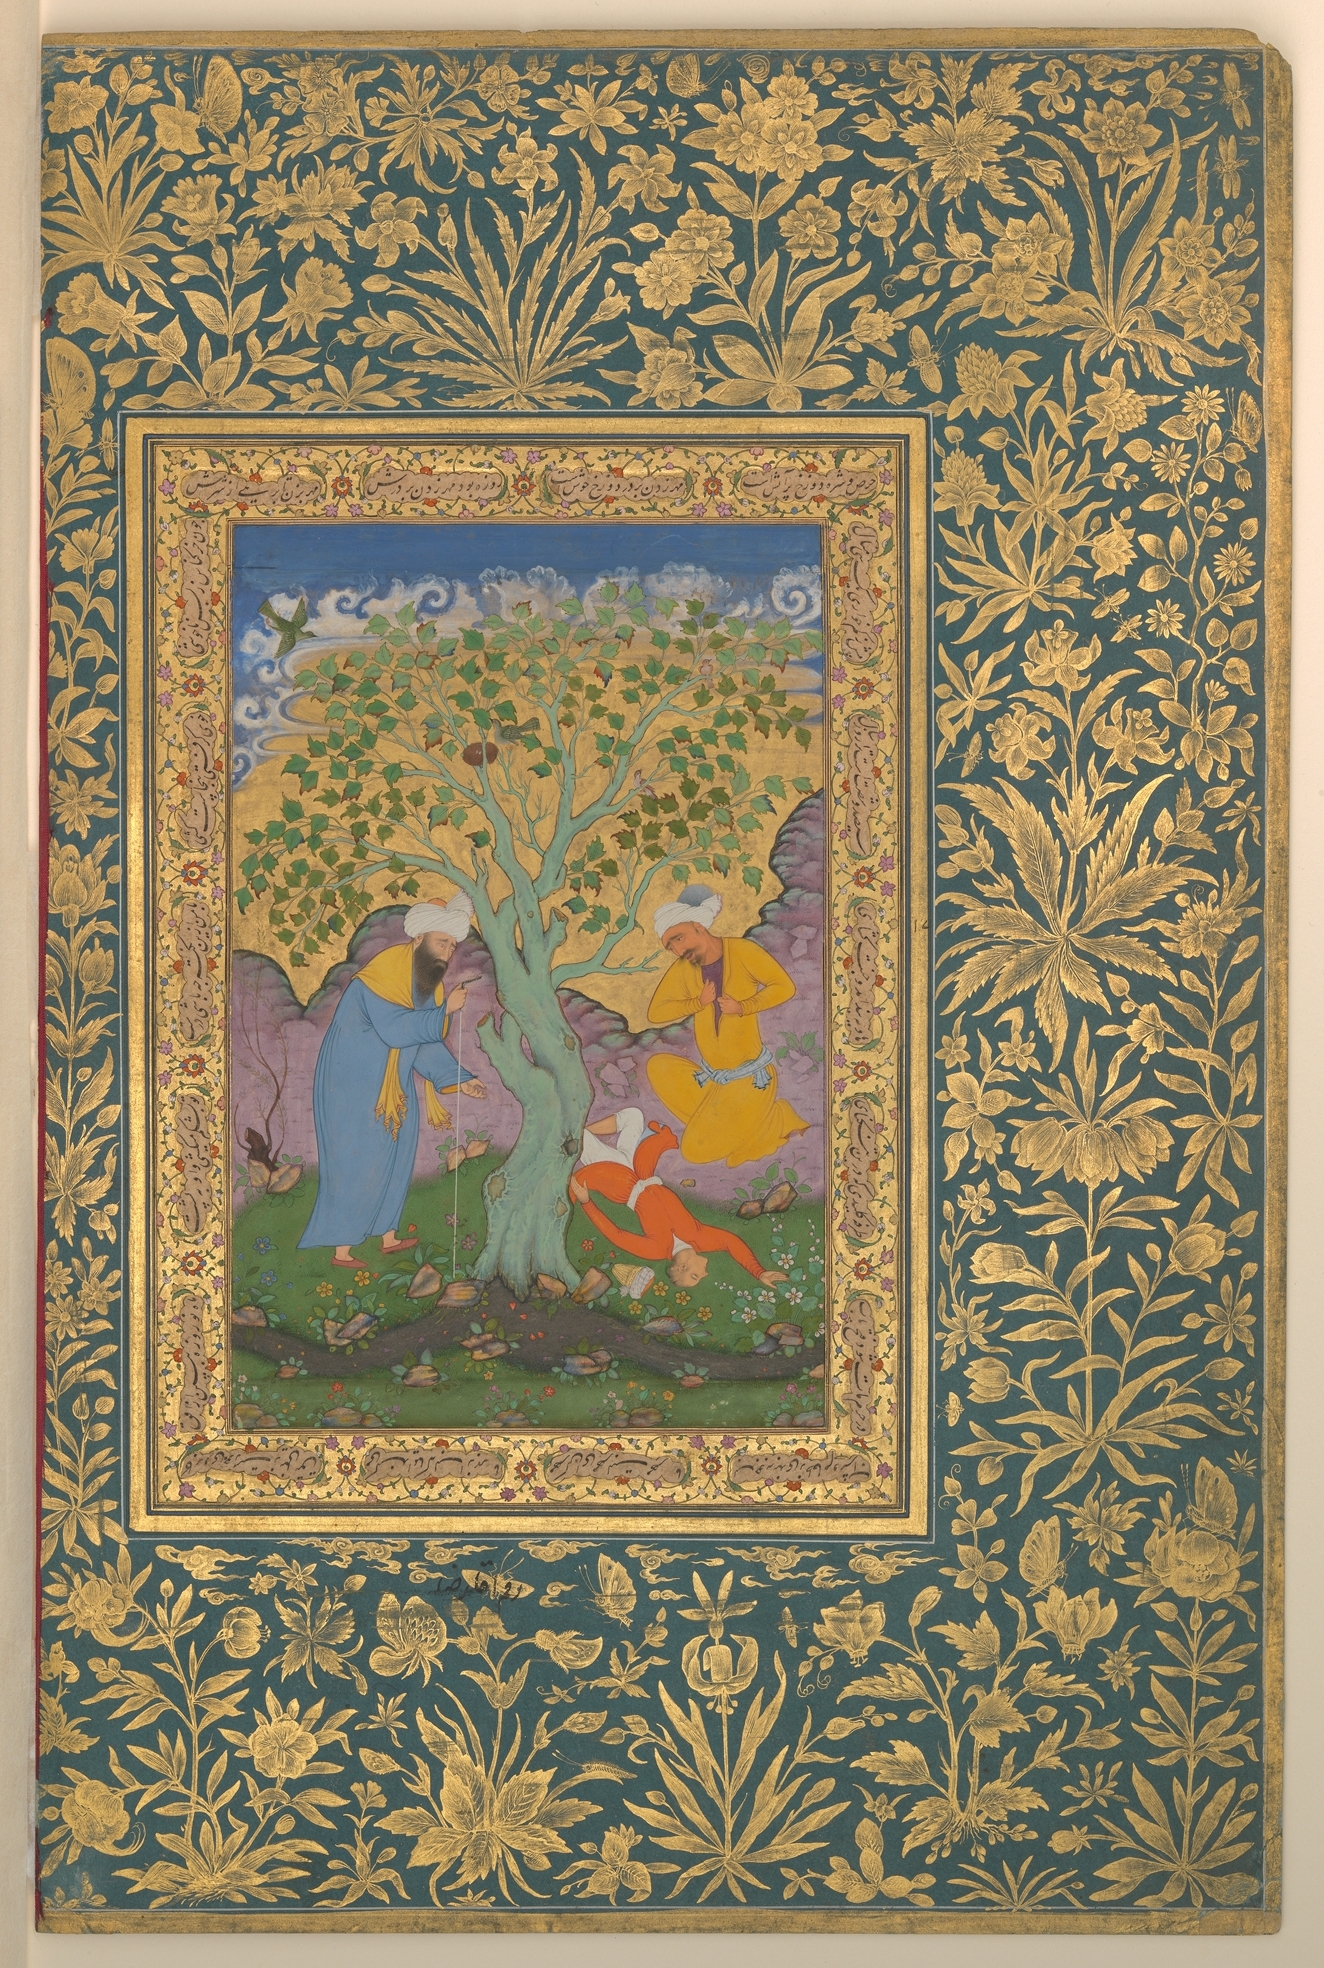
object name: album leaf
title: "A Youth Fallen From a Tree", Folio from the Shah Jahan Album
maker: aqa riza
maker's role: artist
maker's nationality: iranian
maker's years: 1560-1621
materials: gold, ink, paper, watercolor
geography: india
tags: men,trees